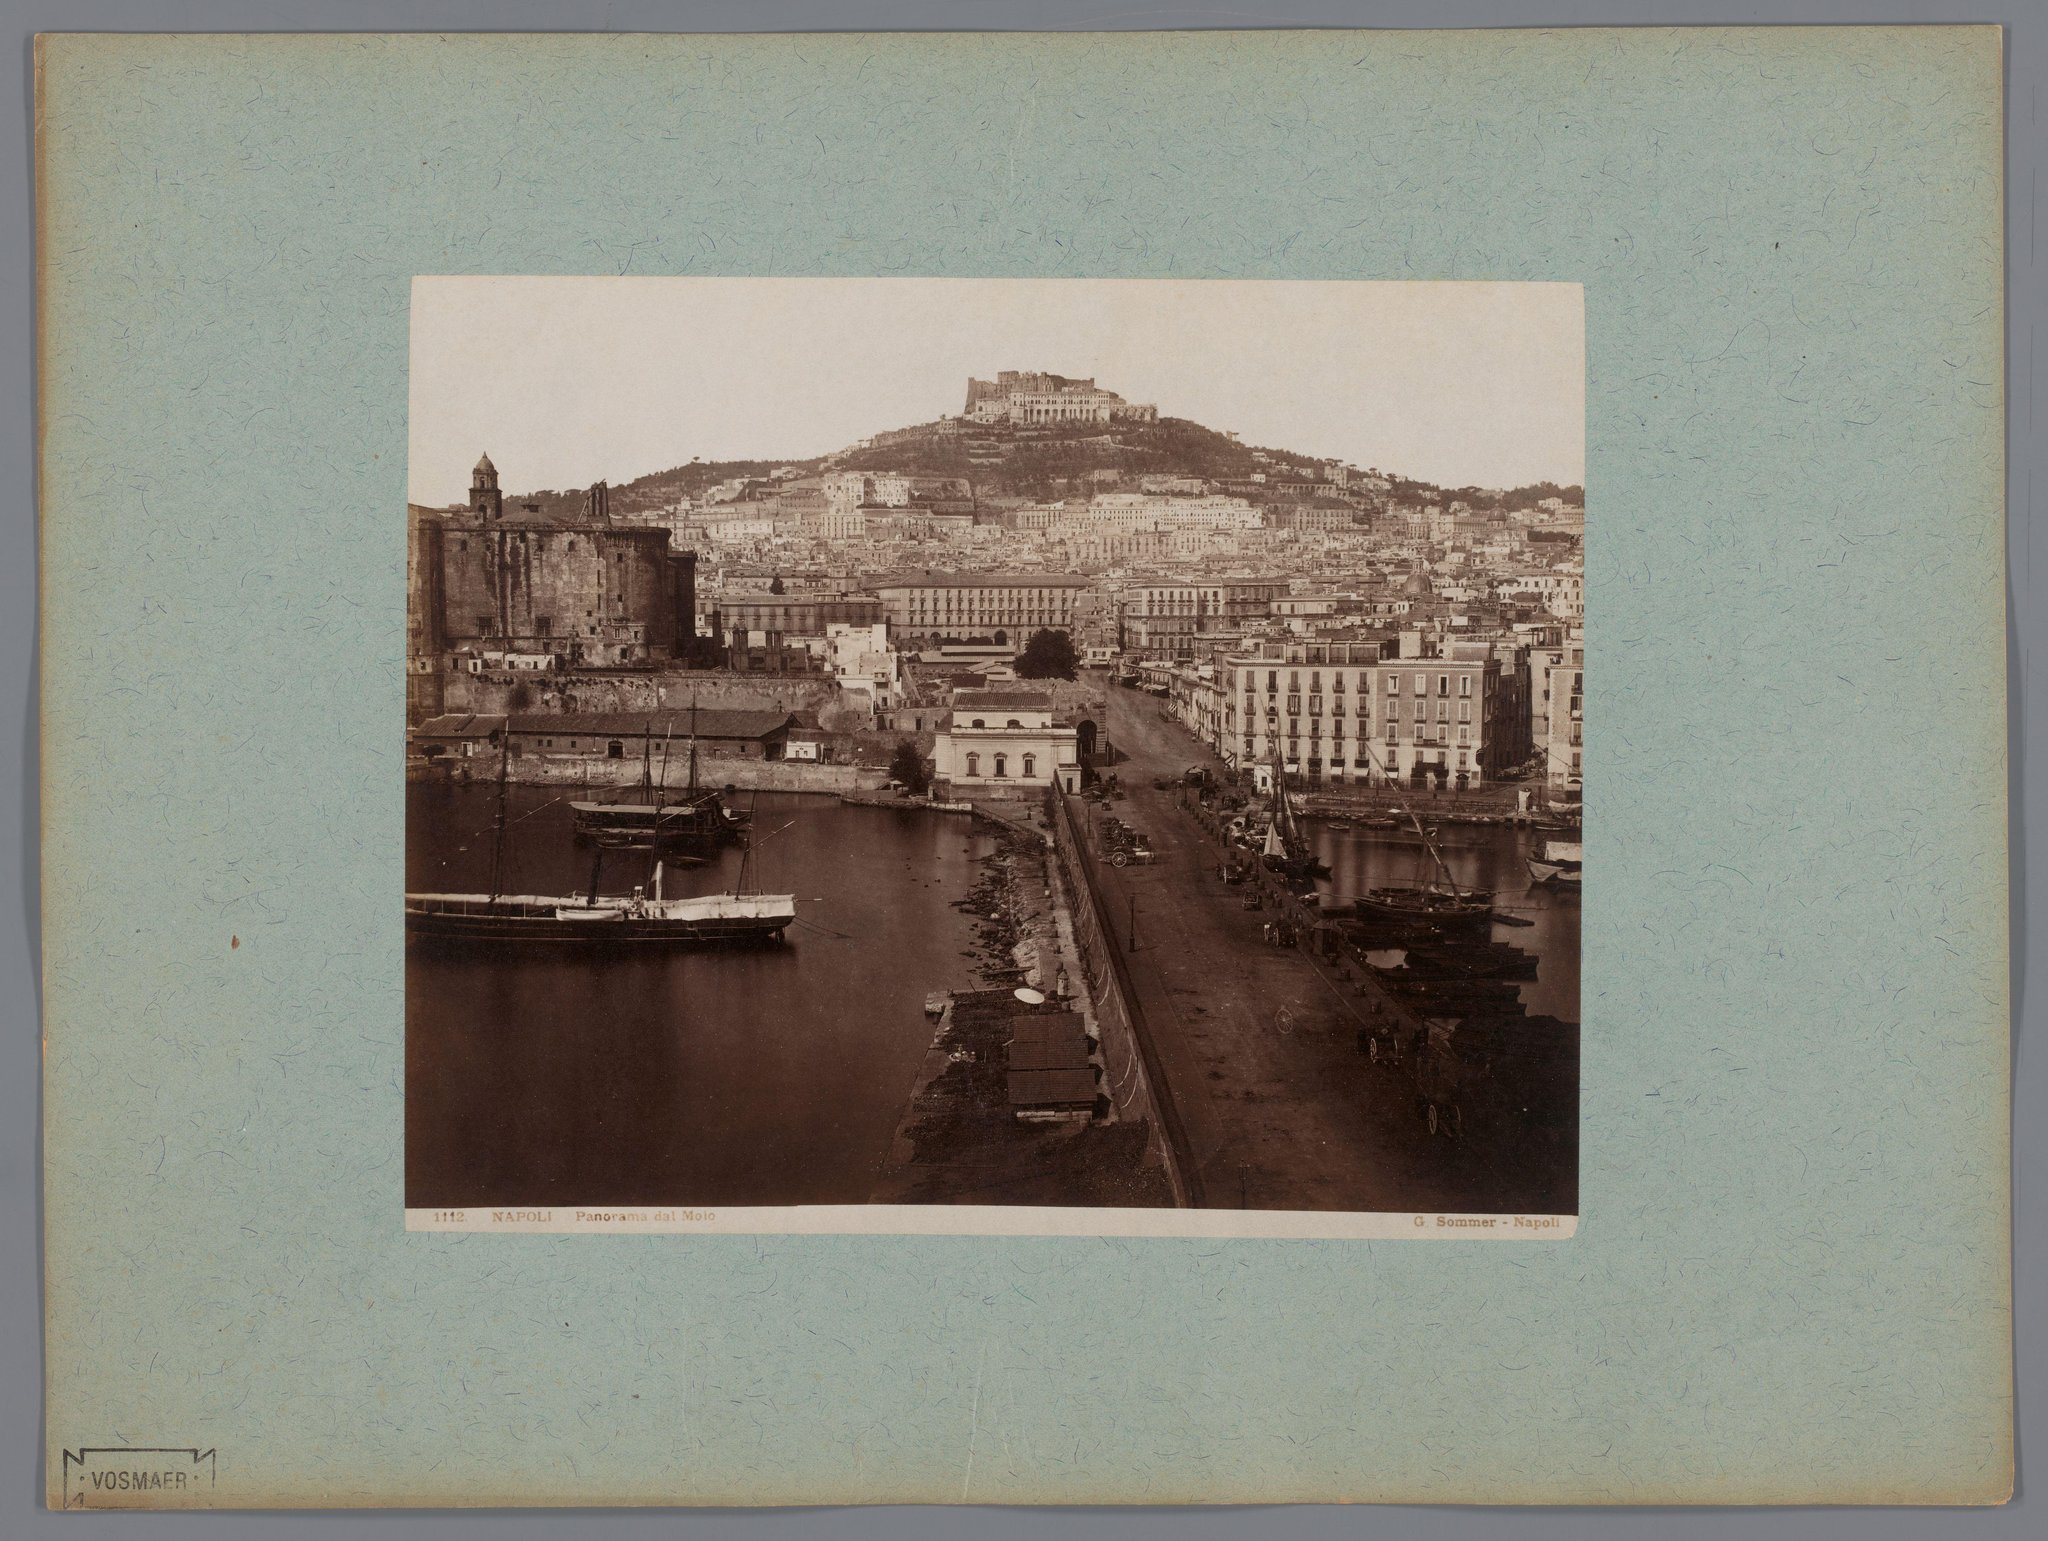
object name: photograph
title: Napoli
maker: giorgio sommer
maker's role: fotograaf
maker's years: 1834-1914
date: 1857-1914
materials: cardboard, paper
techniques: albumen print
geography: naples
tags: city-view in general; 'veduta', castle, street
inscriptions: number: ‘1112.’, collector's mark: ‘VOSMAER’